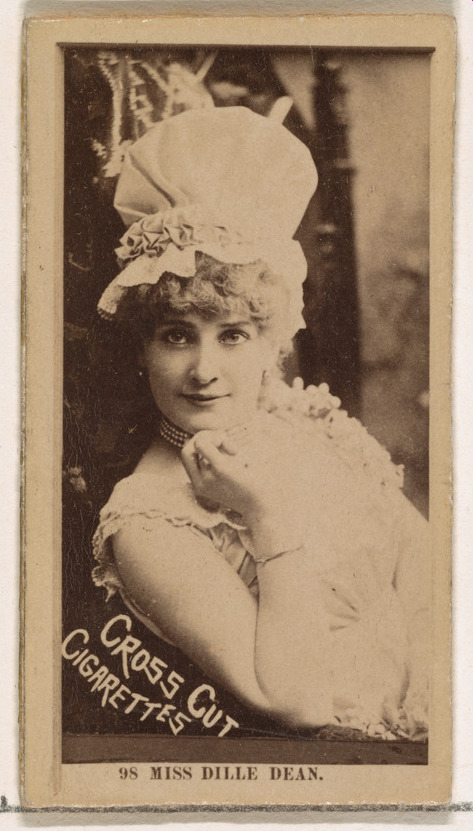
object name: print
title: Card Number 98, Miss Dille Dean, from the Actors and Actresses series (N145-2) issued by Duke Sons & Co. to promote Cross Cut Cigarettes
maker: w. duke, sons & co.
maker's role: publisher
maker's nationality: american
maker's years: 1870-1920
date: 1880-1889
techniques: albumen silver print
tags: portraits,women,actresses